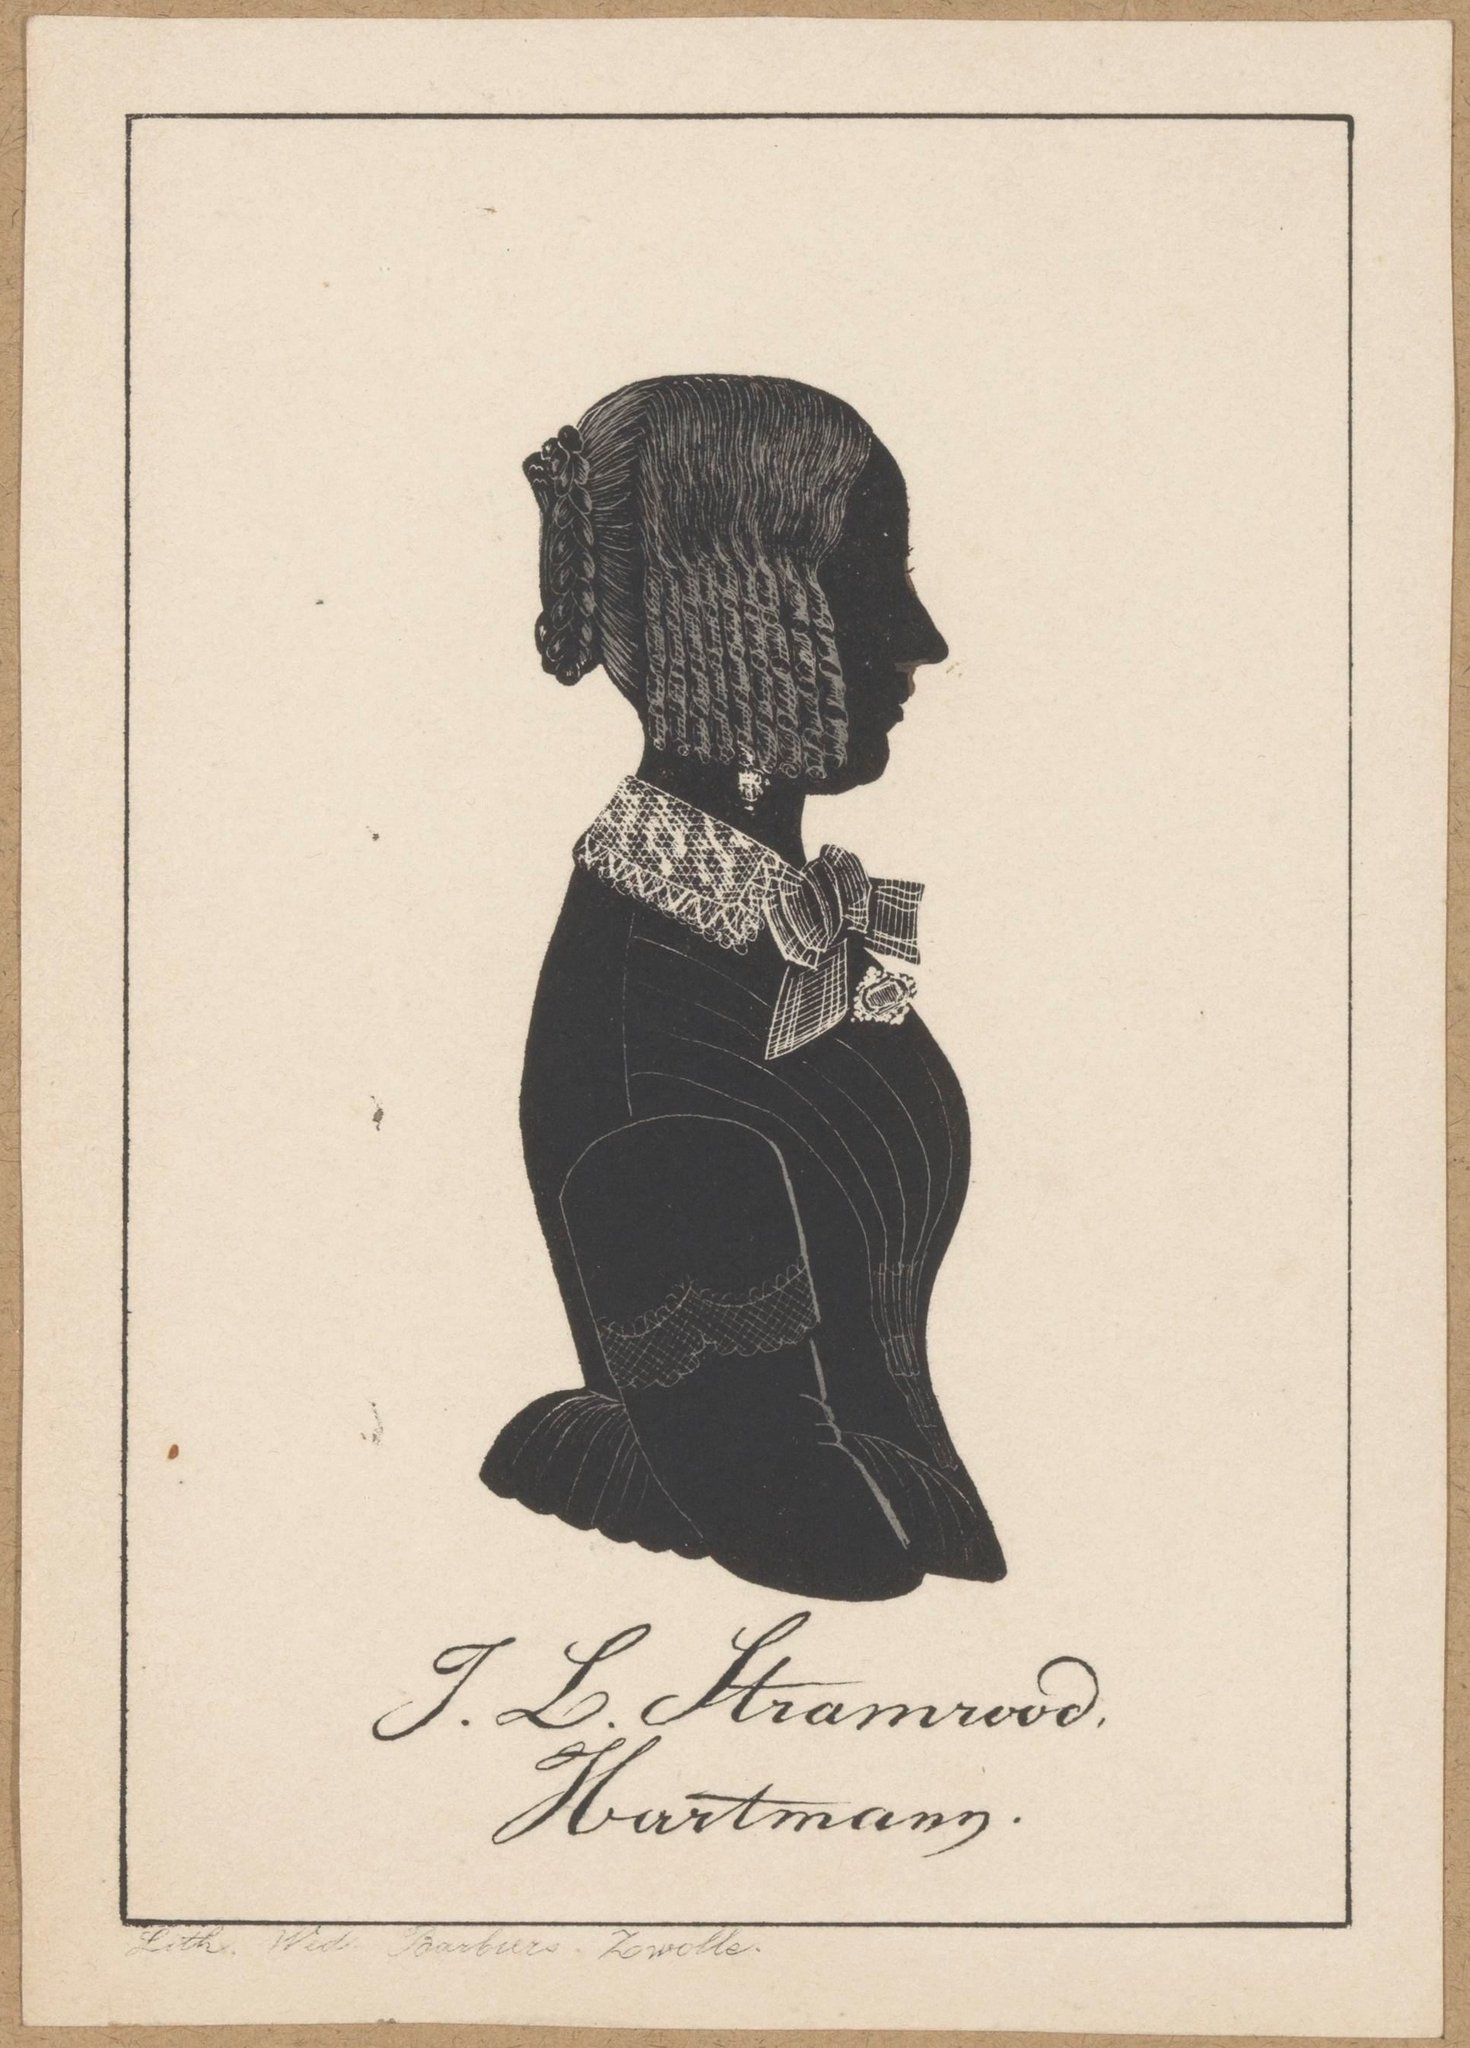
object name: print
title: Silhouetportret van J.L. Stramrood-Hartmann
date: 1848-1862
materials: paper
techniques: hand coloring, lithograph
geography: netherlands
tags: historical persons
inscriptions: collector's mark: Lugt 2228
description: Onder het portret de signatuur van de geportretteerde.